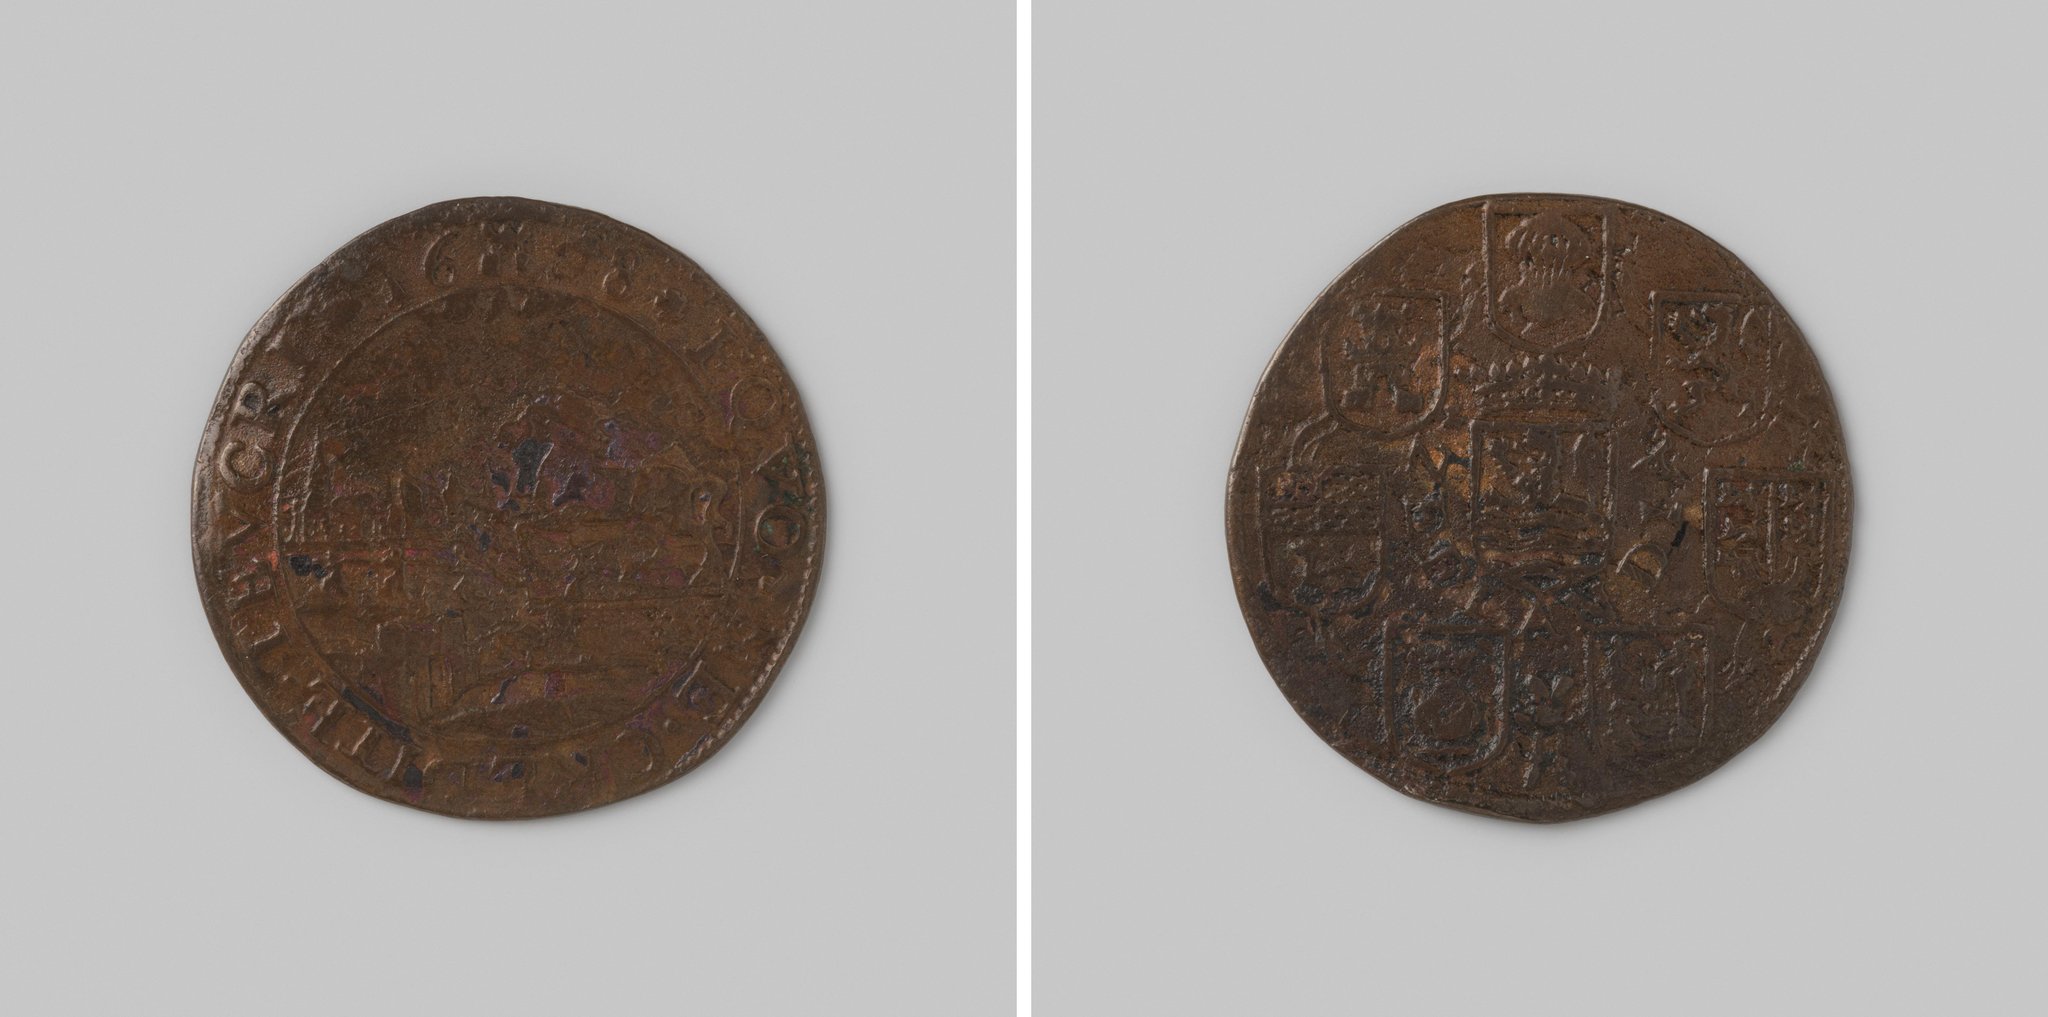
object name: history medal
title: Rekenpenning uit Middelburg op de bedrieglijkheid van het bestand 1608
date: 1608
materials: copper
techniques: striking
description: Koperen penning, op de voorzijde het binnenhalen van het Paard van Troje, met omschrift, op de keerzijde het gekroonde wapenschild van Zeeland met omschrift, waaromheen zeven stadswapenscjilden met een lint verbonden.